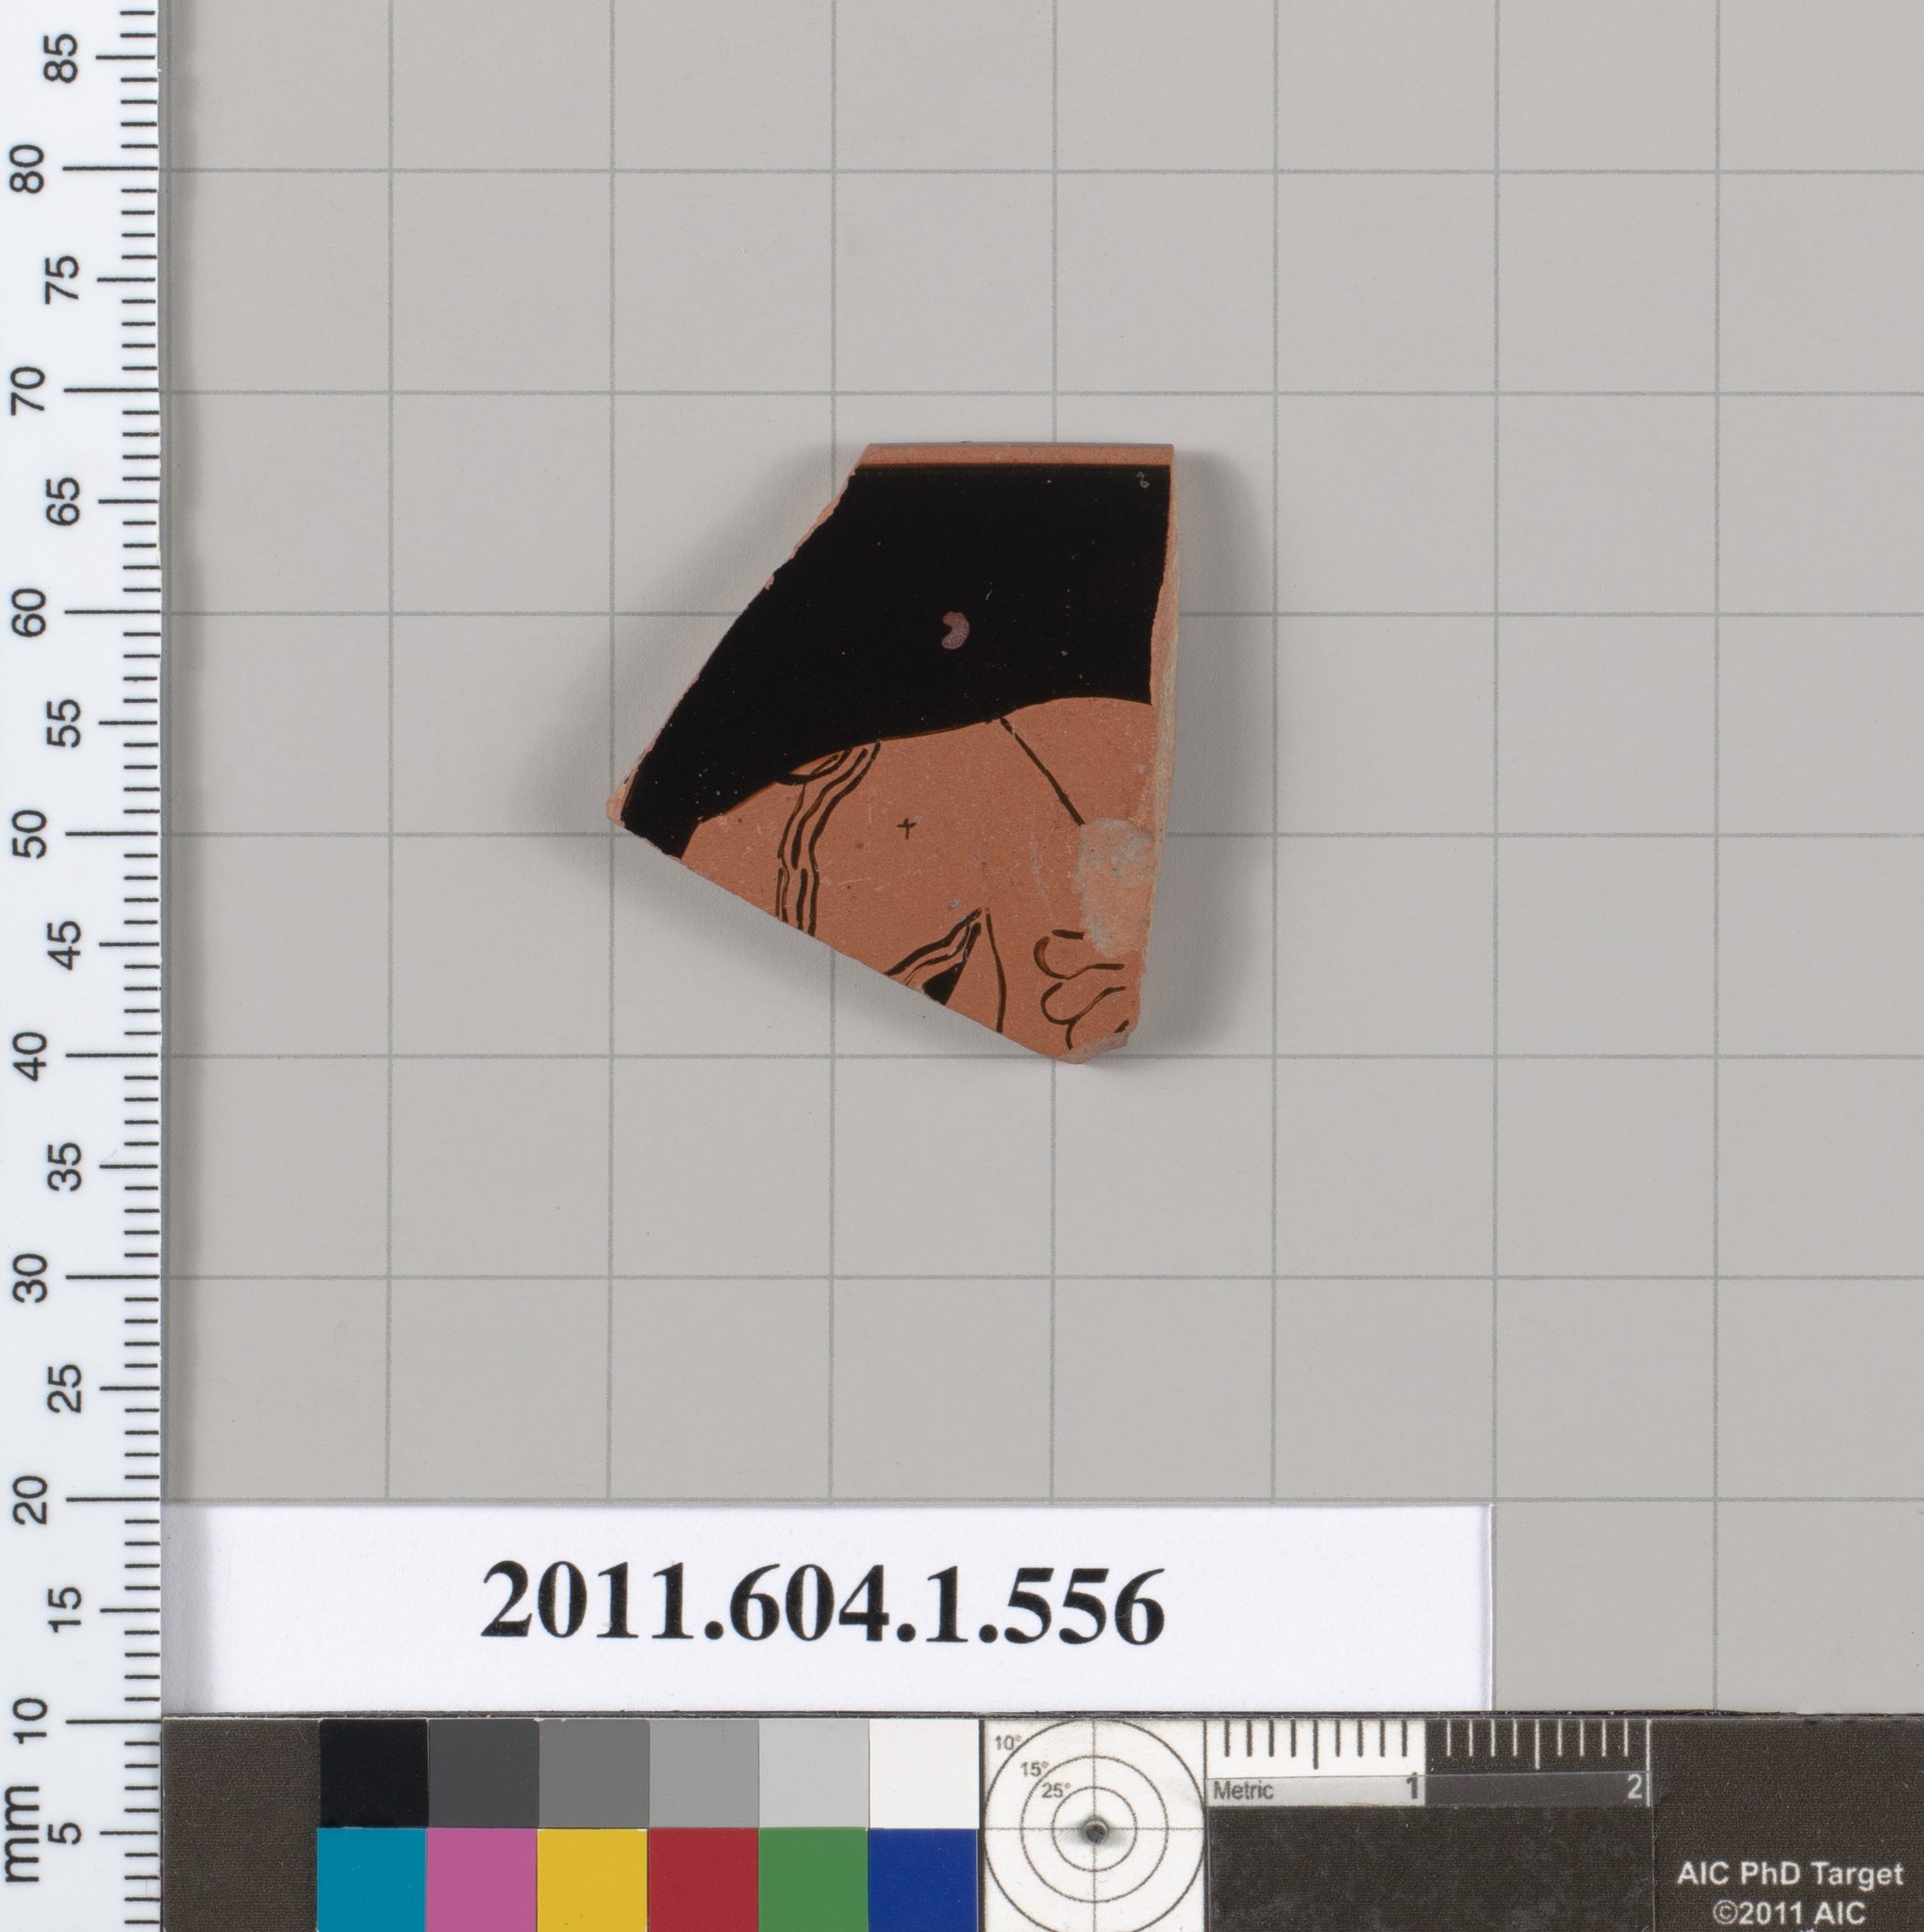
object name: kylix fragment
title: Terracotta rim fragment of a kylix (drinking cup)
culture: greek, attic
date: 480-470 BCE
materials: terracotta